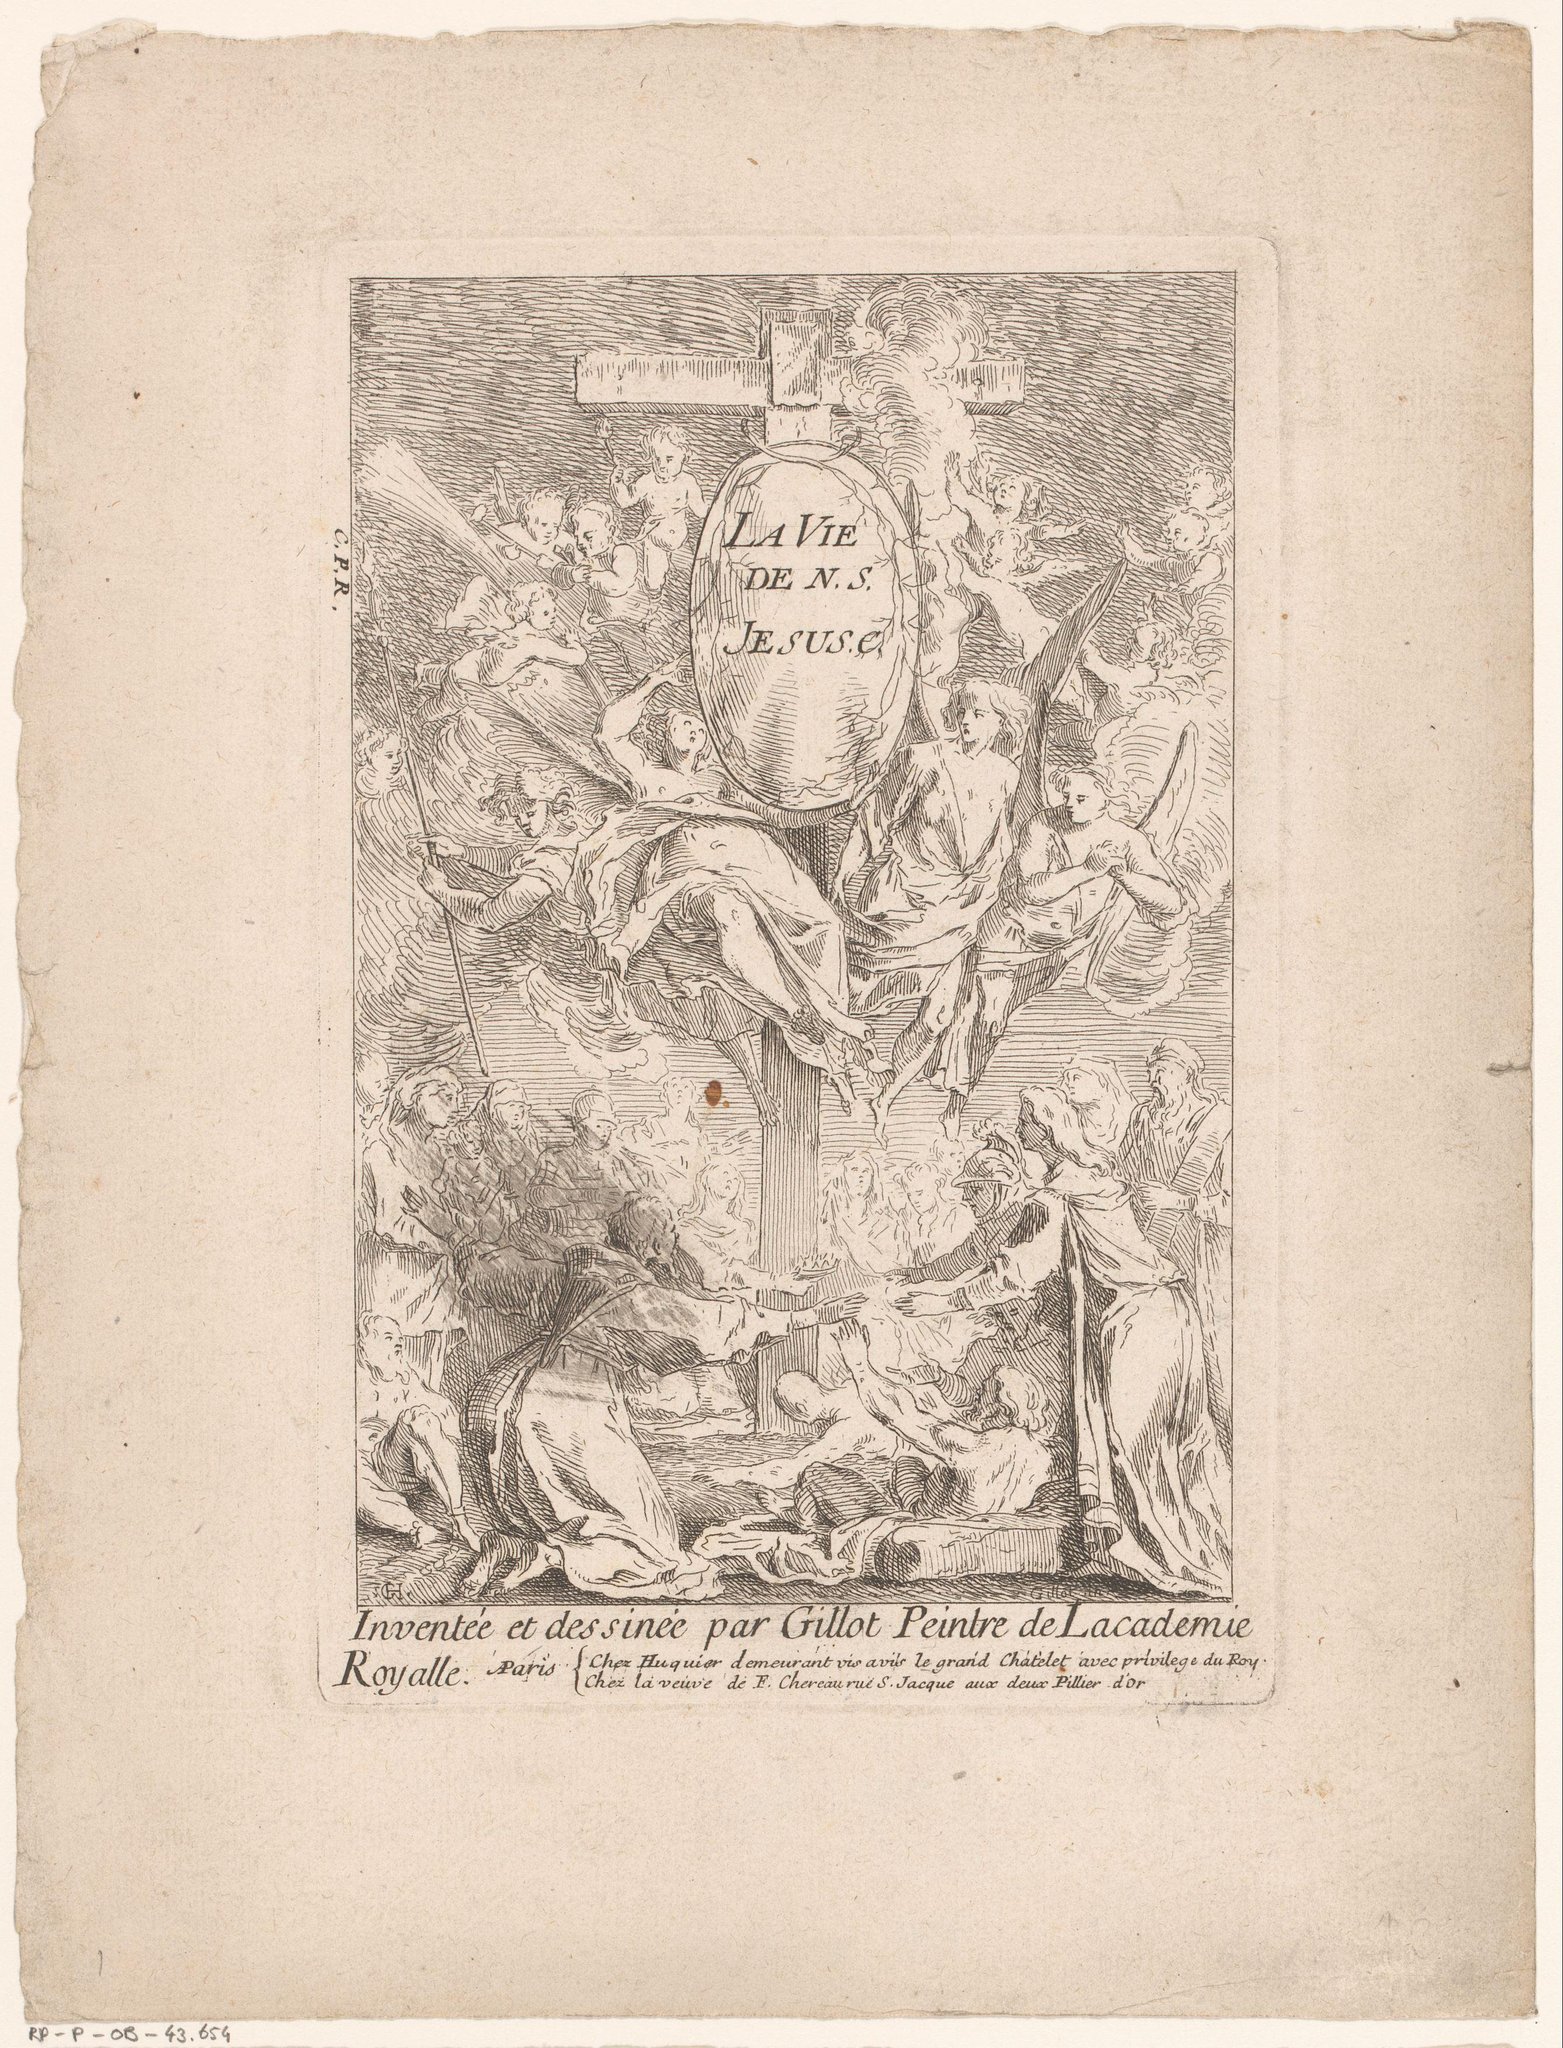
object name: titelprent, frontispice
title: Leven en passie van Christus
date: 1705-1732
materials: paper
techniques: etching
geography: paris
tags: venerating the cross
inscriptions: collector's mark: Lugt 2228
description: Titelprent van een serie met zestig prenten met als thema het leven van Christus.